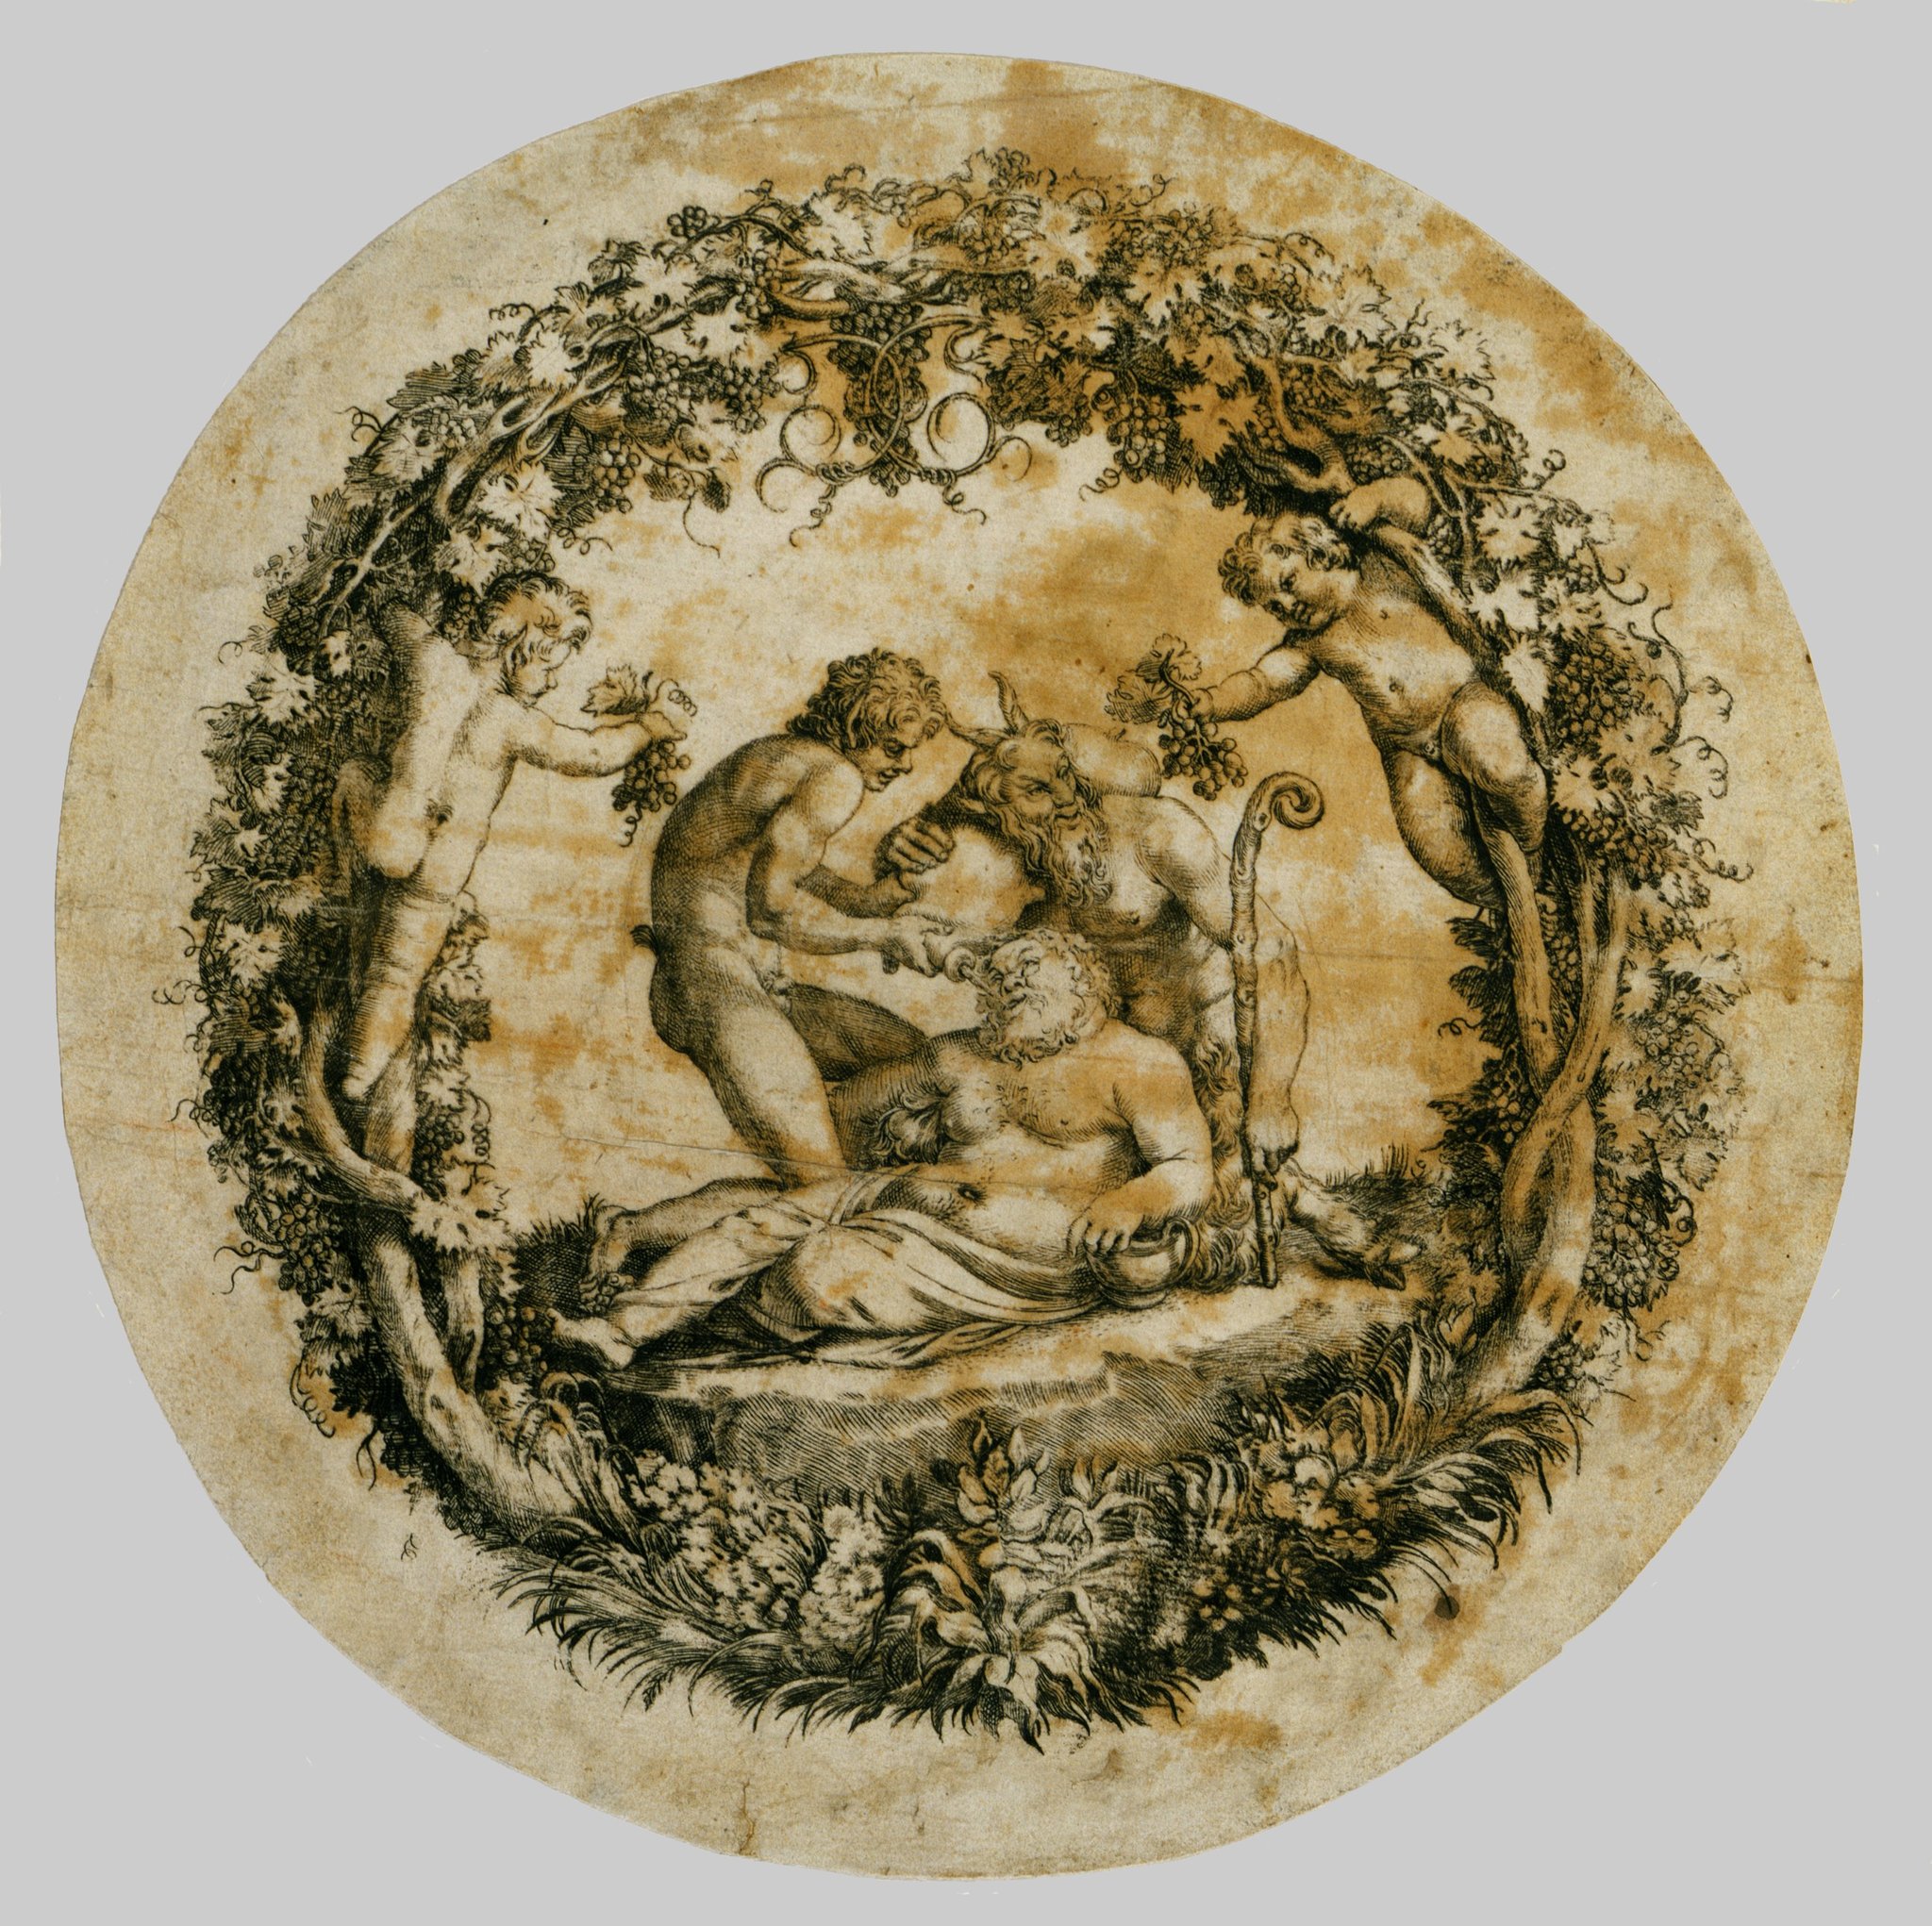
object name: print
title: Wilton album, folio 41: The Drunken Silenus (Tazza Farnese)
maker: annibale carracci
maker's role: artist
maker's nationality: italian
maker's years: 1560-1609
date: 1597-1600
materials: silver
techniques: engraving, printing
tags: drunkenness,children,silenus,satyrs,drinking